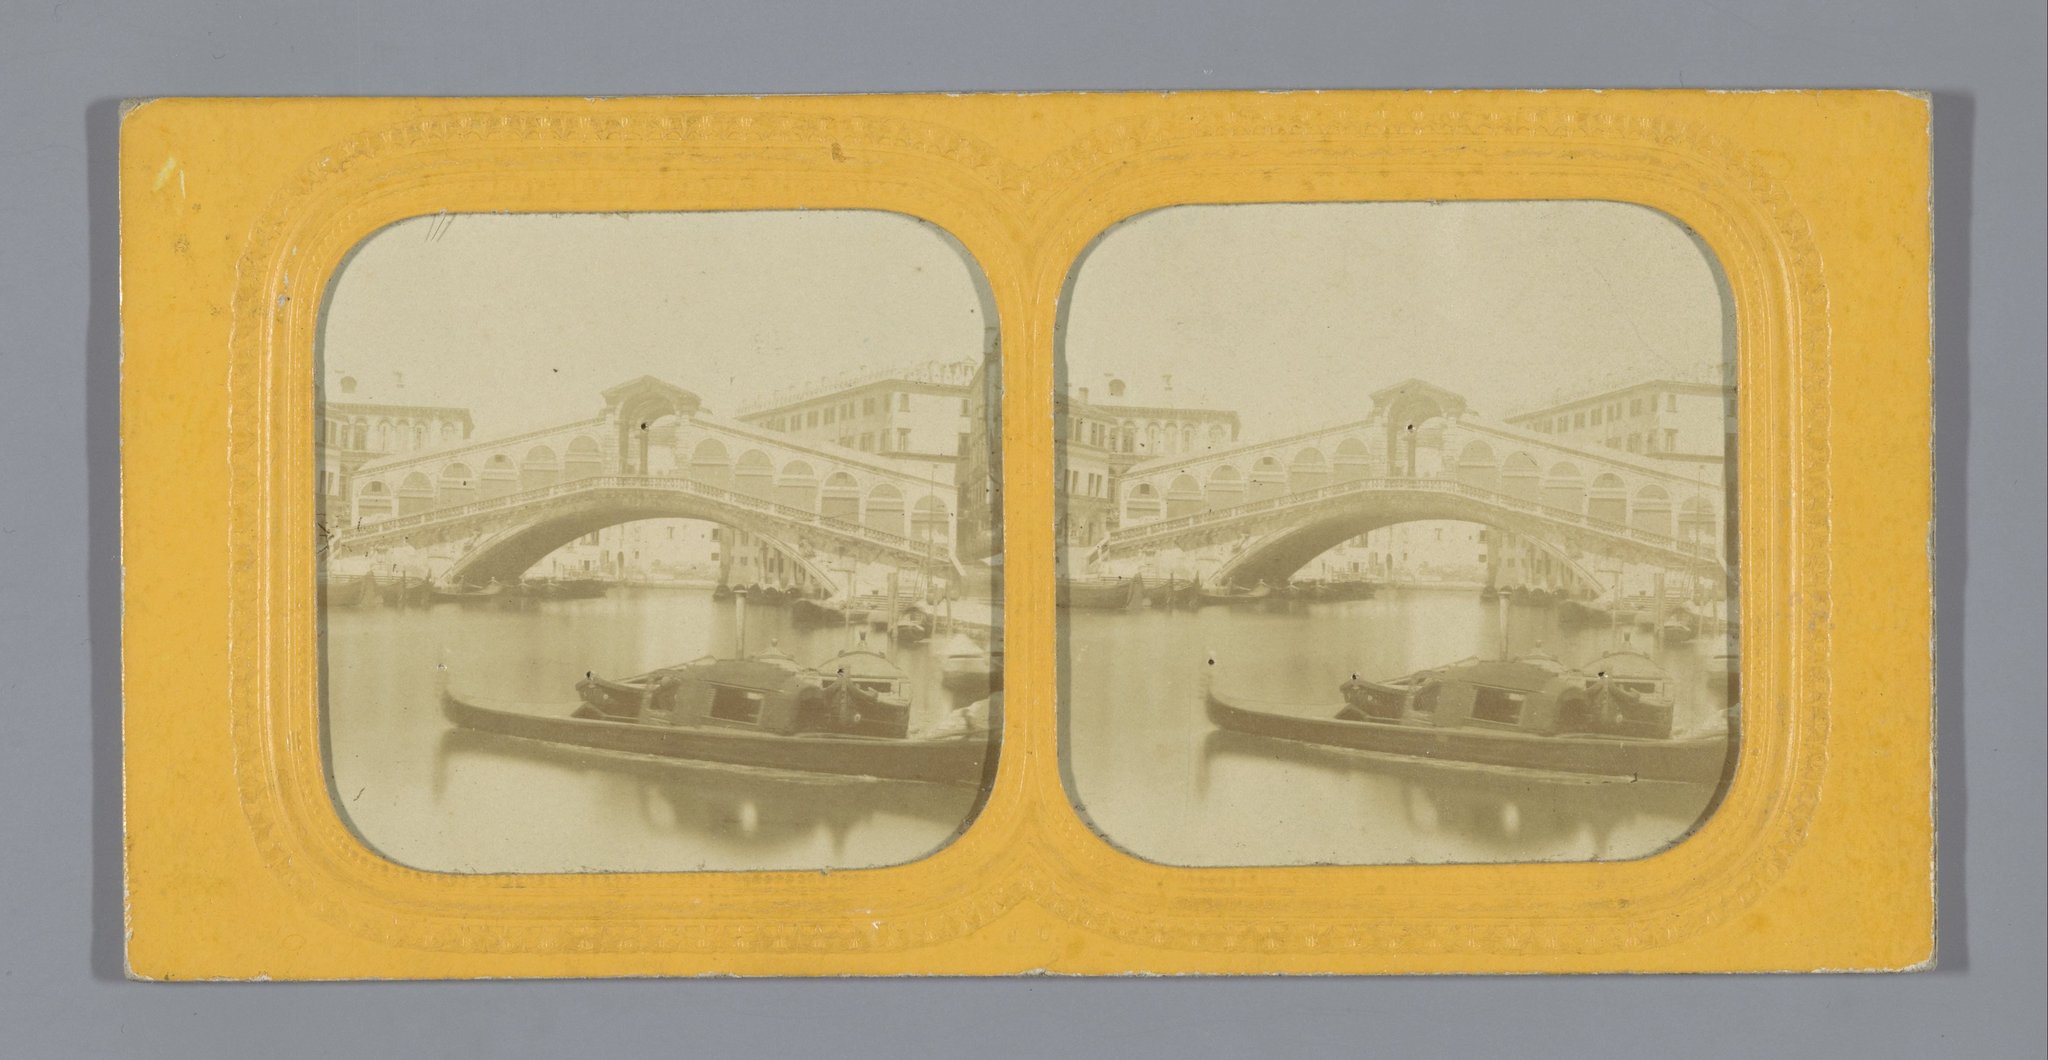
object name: tissue stereograph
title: Pont de Rialto, Venise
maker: Anonymous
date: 1855-1875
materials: cardboard, paper, photographic support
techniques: albumen print, hand coloring, perforating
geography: venice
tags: bridge in city across river, canal, etc.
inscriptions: number: ‘N6-’, number: ‘No. 91’